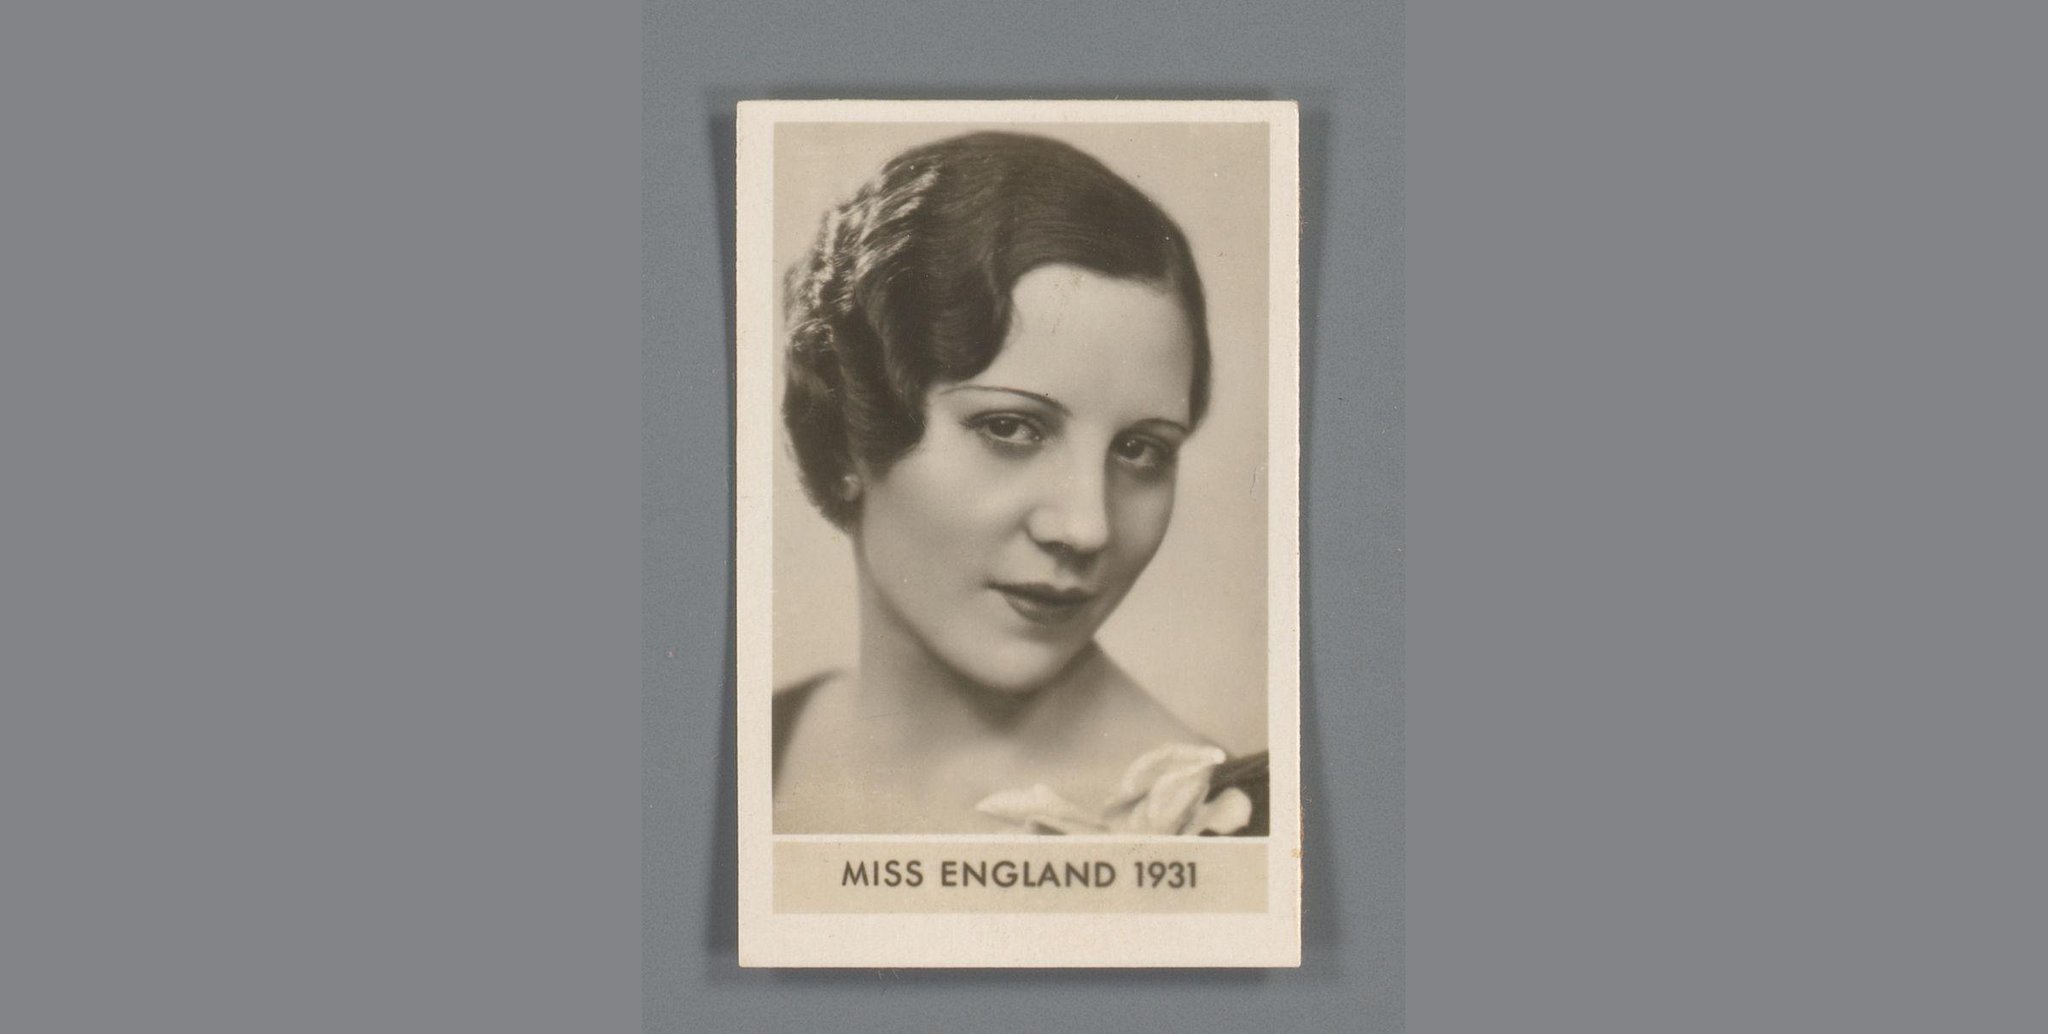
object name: photograph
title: Miss England 1931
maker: Anonymous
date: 1931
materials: paper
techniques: gelatin silver print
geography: dresden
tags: historical persons - bb - woman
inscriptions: inscription: ‘Die schönsten/ Frauen der Welt/ dargestellt durch die Schön-/ heitsköniginnen aller Länder,/ finden Sie in 190 echten/ Bromsilber-Fotos, die nur den/ CLUB-und-LIGA-Packun-/ gen beiliegen. Eind prächtiges/ Sammel-Album erhalten Sie/ für 75 Pfennig vom Händler/ oder bei Einsendung von/ 75 Pfennig in Briefmarken/ von der Bilderstelle Lohse,/ Dresden A24, Nossener Str. 1./ Ges. gesch. Nachdruck verboten!’